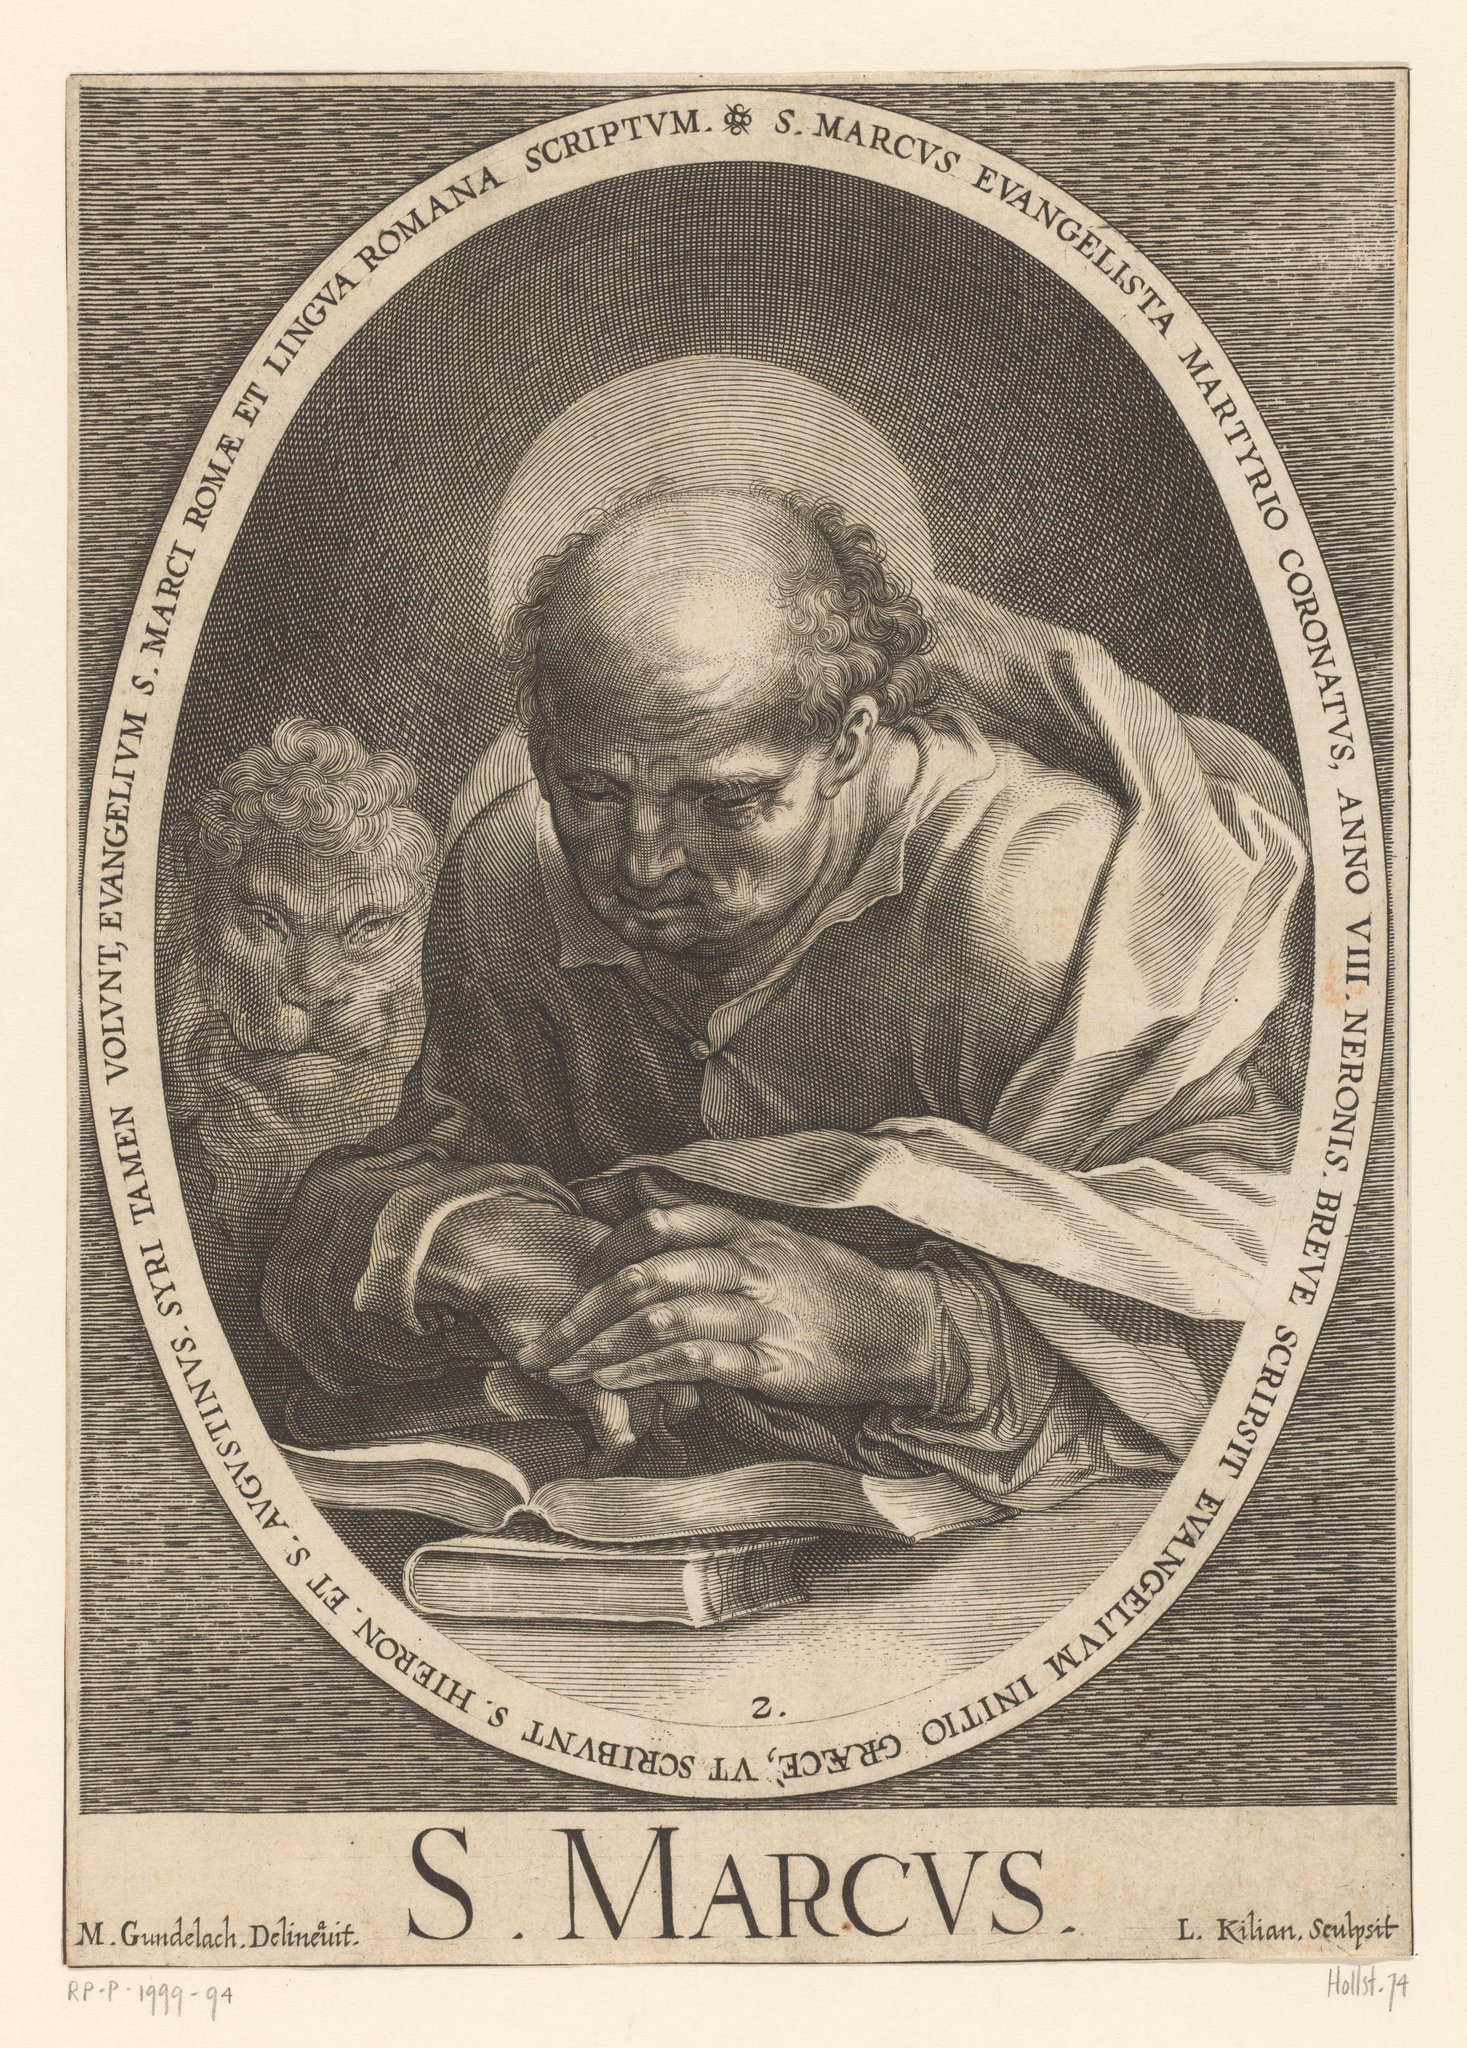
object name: print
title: Beeltenissen van de Heilige Evangelisten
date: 1629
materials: paper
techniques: engraving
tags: mark (marcus) the evangelist, and bishop of alexandria; possible attributes: book, (winged) lion, pen and inkhorn, scroll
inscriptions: collector's mark: Lugt 2228, collector's mark: Lugt 2760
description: Deze prent maakt deel uit van een serie van vier prenten.